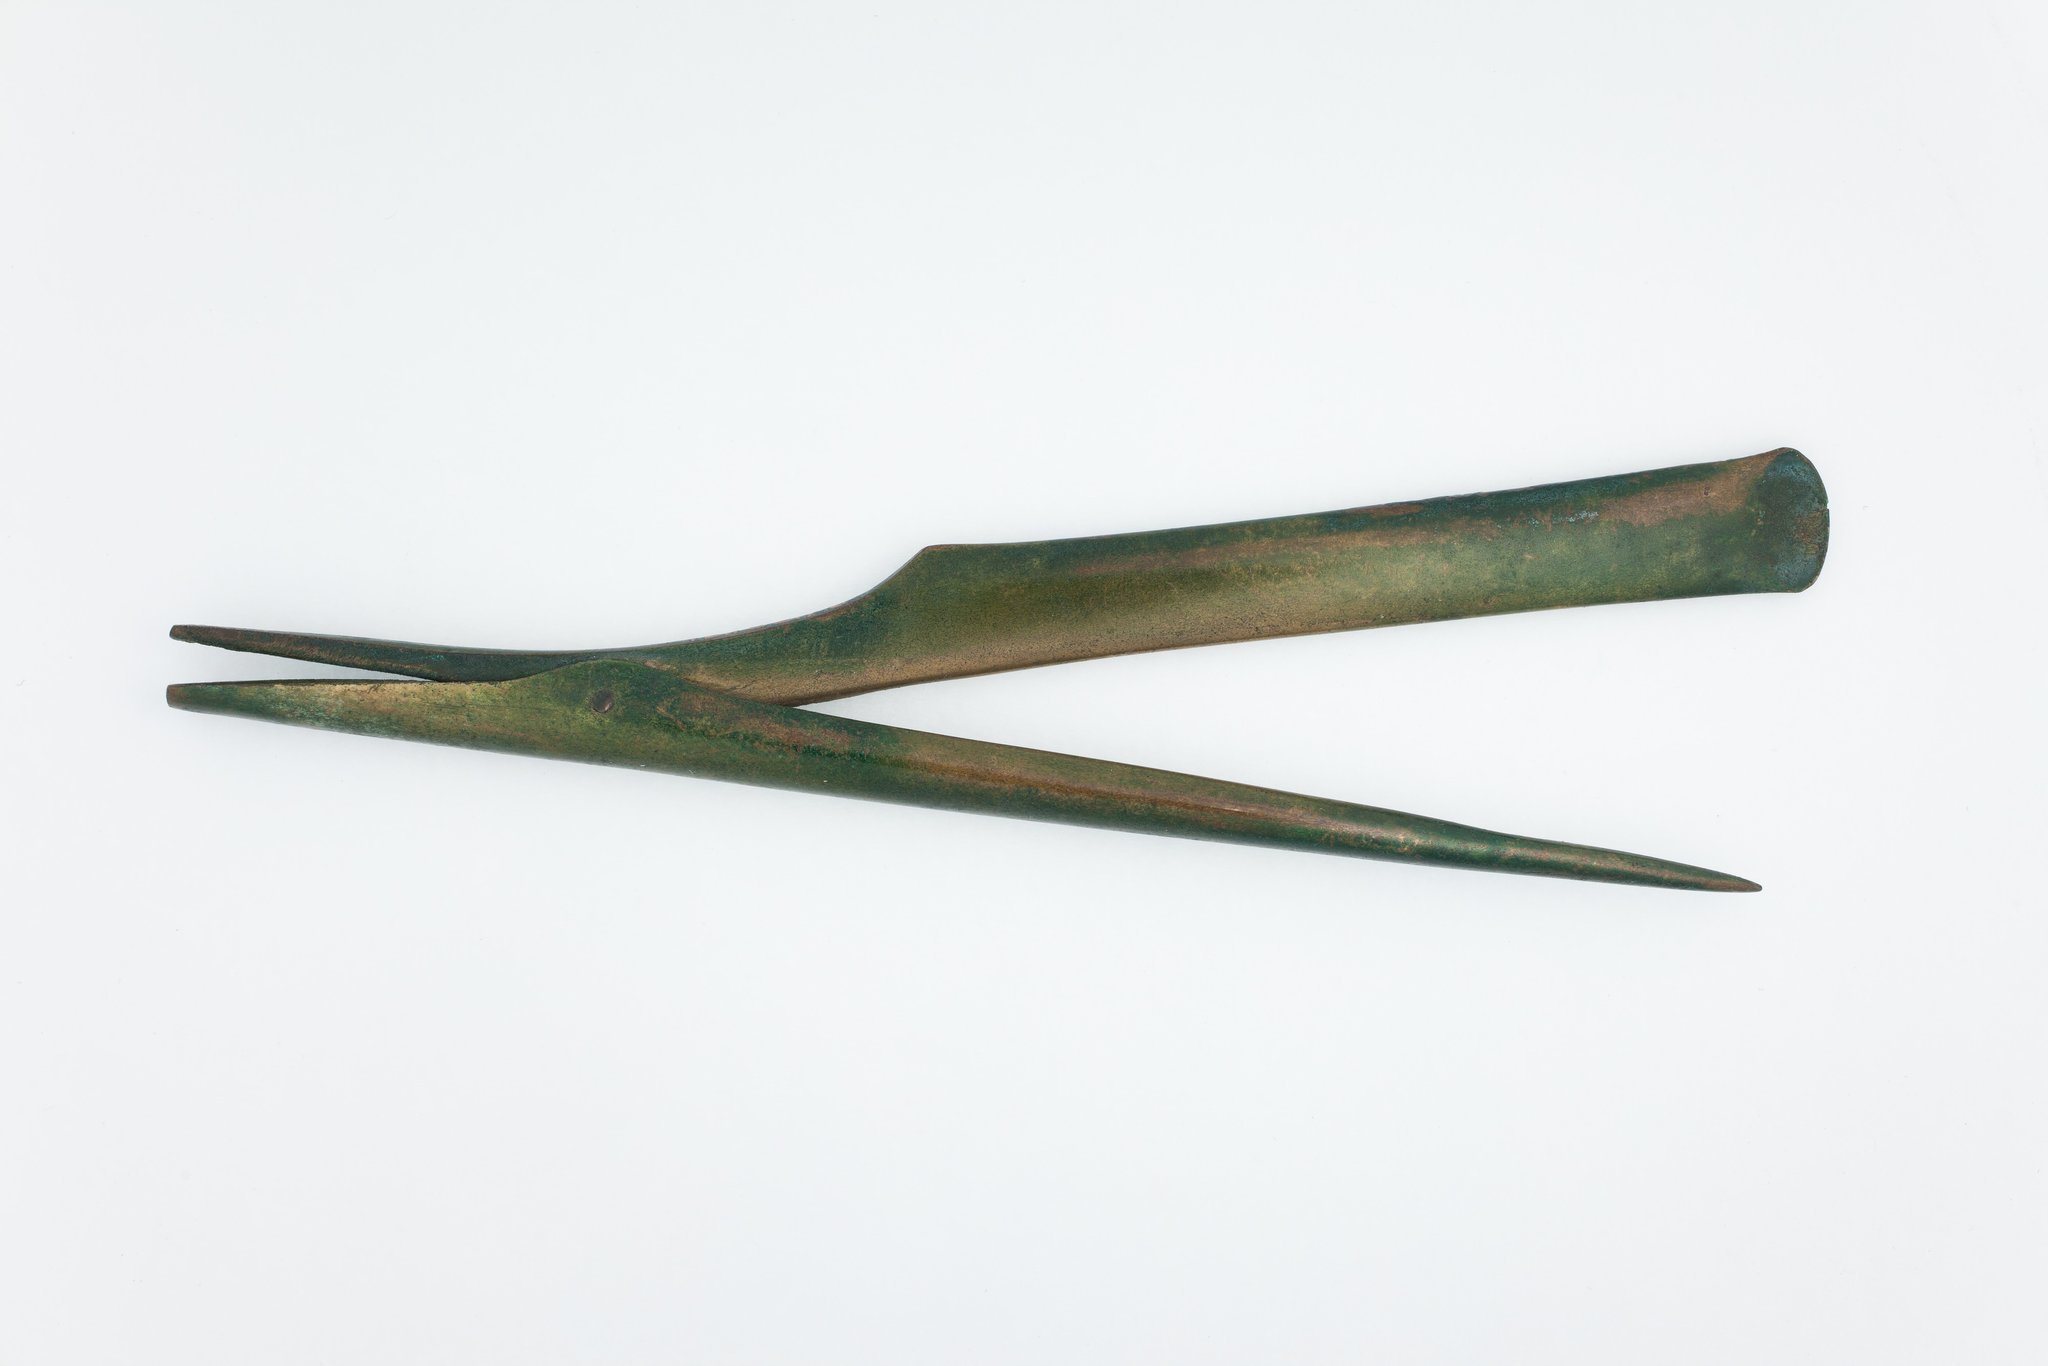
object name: tweezer razor, razor, tweezer, hair curler, knife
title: Tweezer-Razor Implement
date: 1550-1295 BCE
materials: bronze, copper alloy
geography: egypt